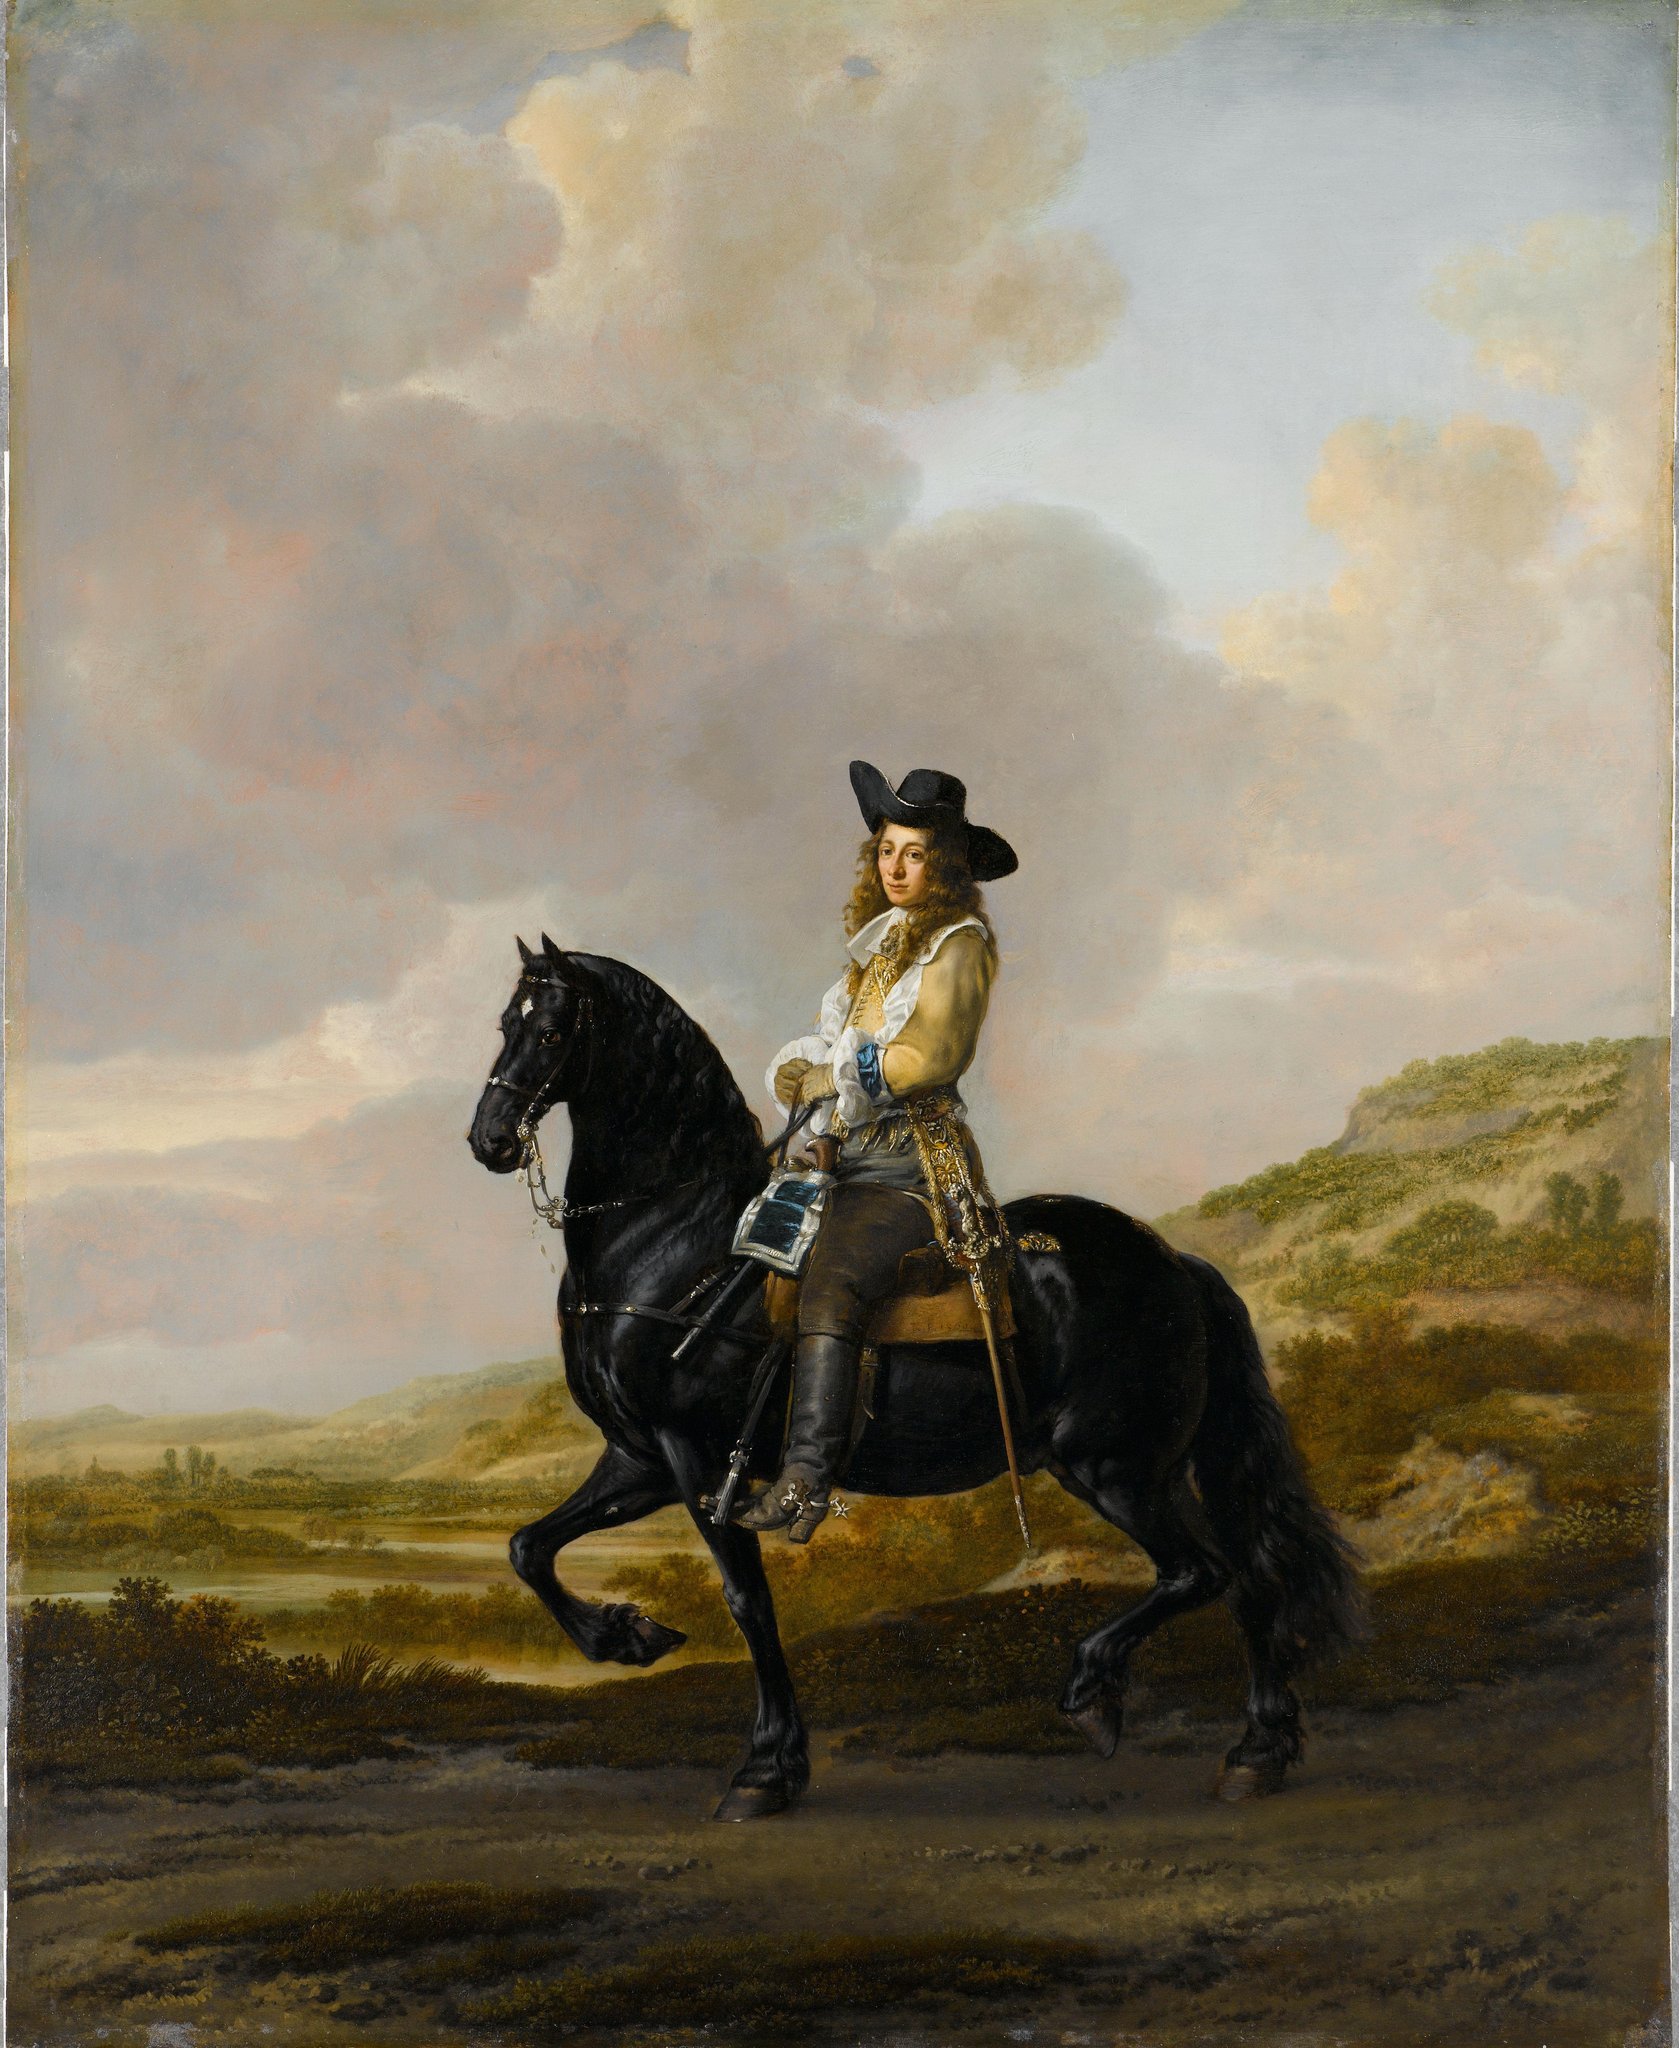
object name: painting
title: Pieter Schout on Horseback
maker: theodorus de keyser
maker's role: draughtsman, painter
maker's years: 1596-1667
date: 1660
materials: copper, oil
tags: equestrian state-portrait, riding a horse, ass, or mule; rider, horseman, historical persons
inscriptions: signature and date, on the saddle, in ligated monogram: ‘TDK.1660’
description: Equestrian portraits were traditionally the reserve of princes. Accordingly, in the Netherlands very few equestrian portraits were made, except for the court. Only a handful of burghers had themselves immortalized on horseback. Pieter Schout was one such citizen who assumed a princely air. He was bailiff – administrative officer – of Hagestein on the River Lek.